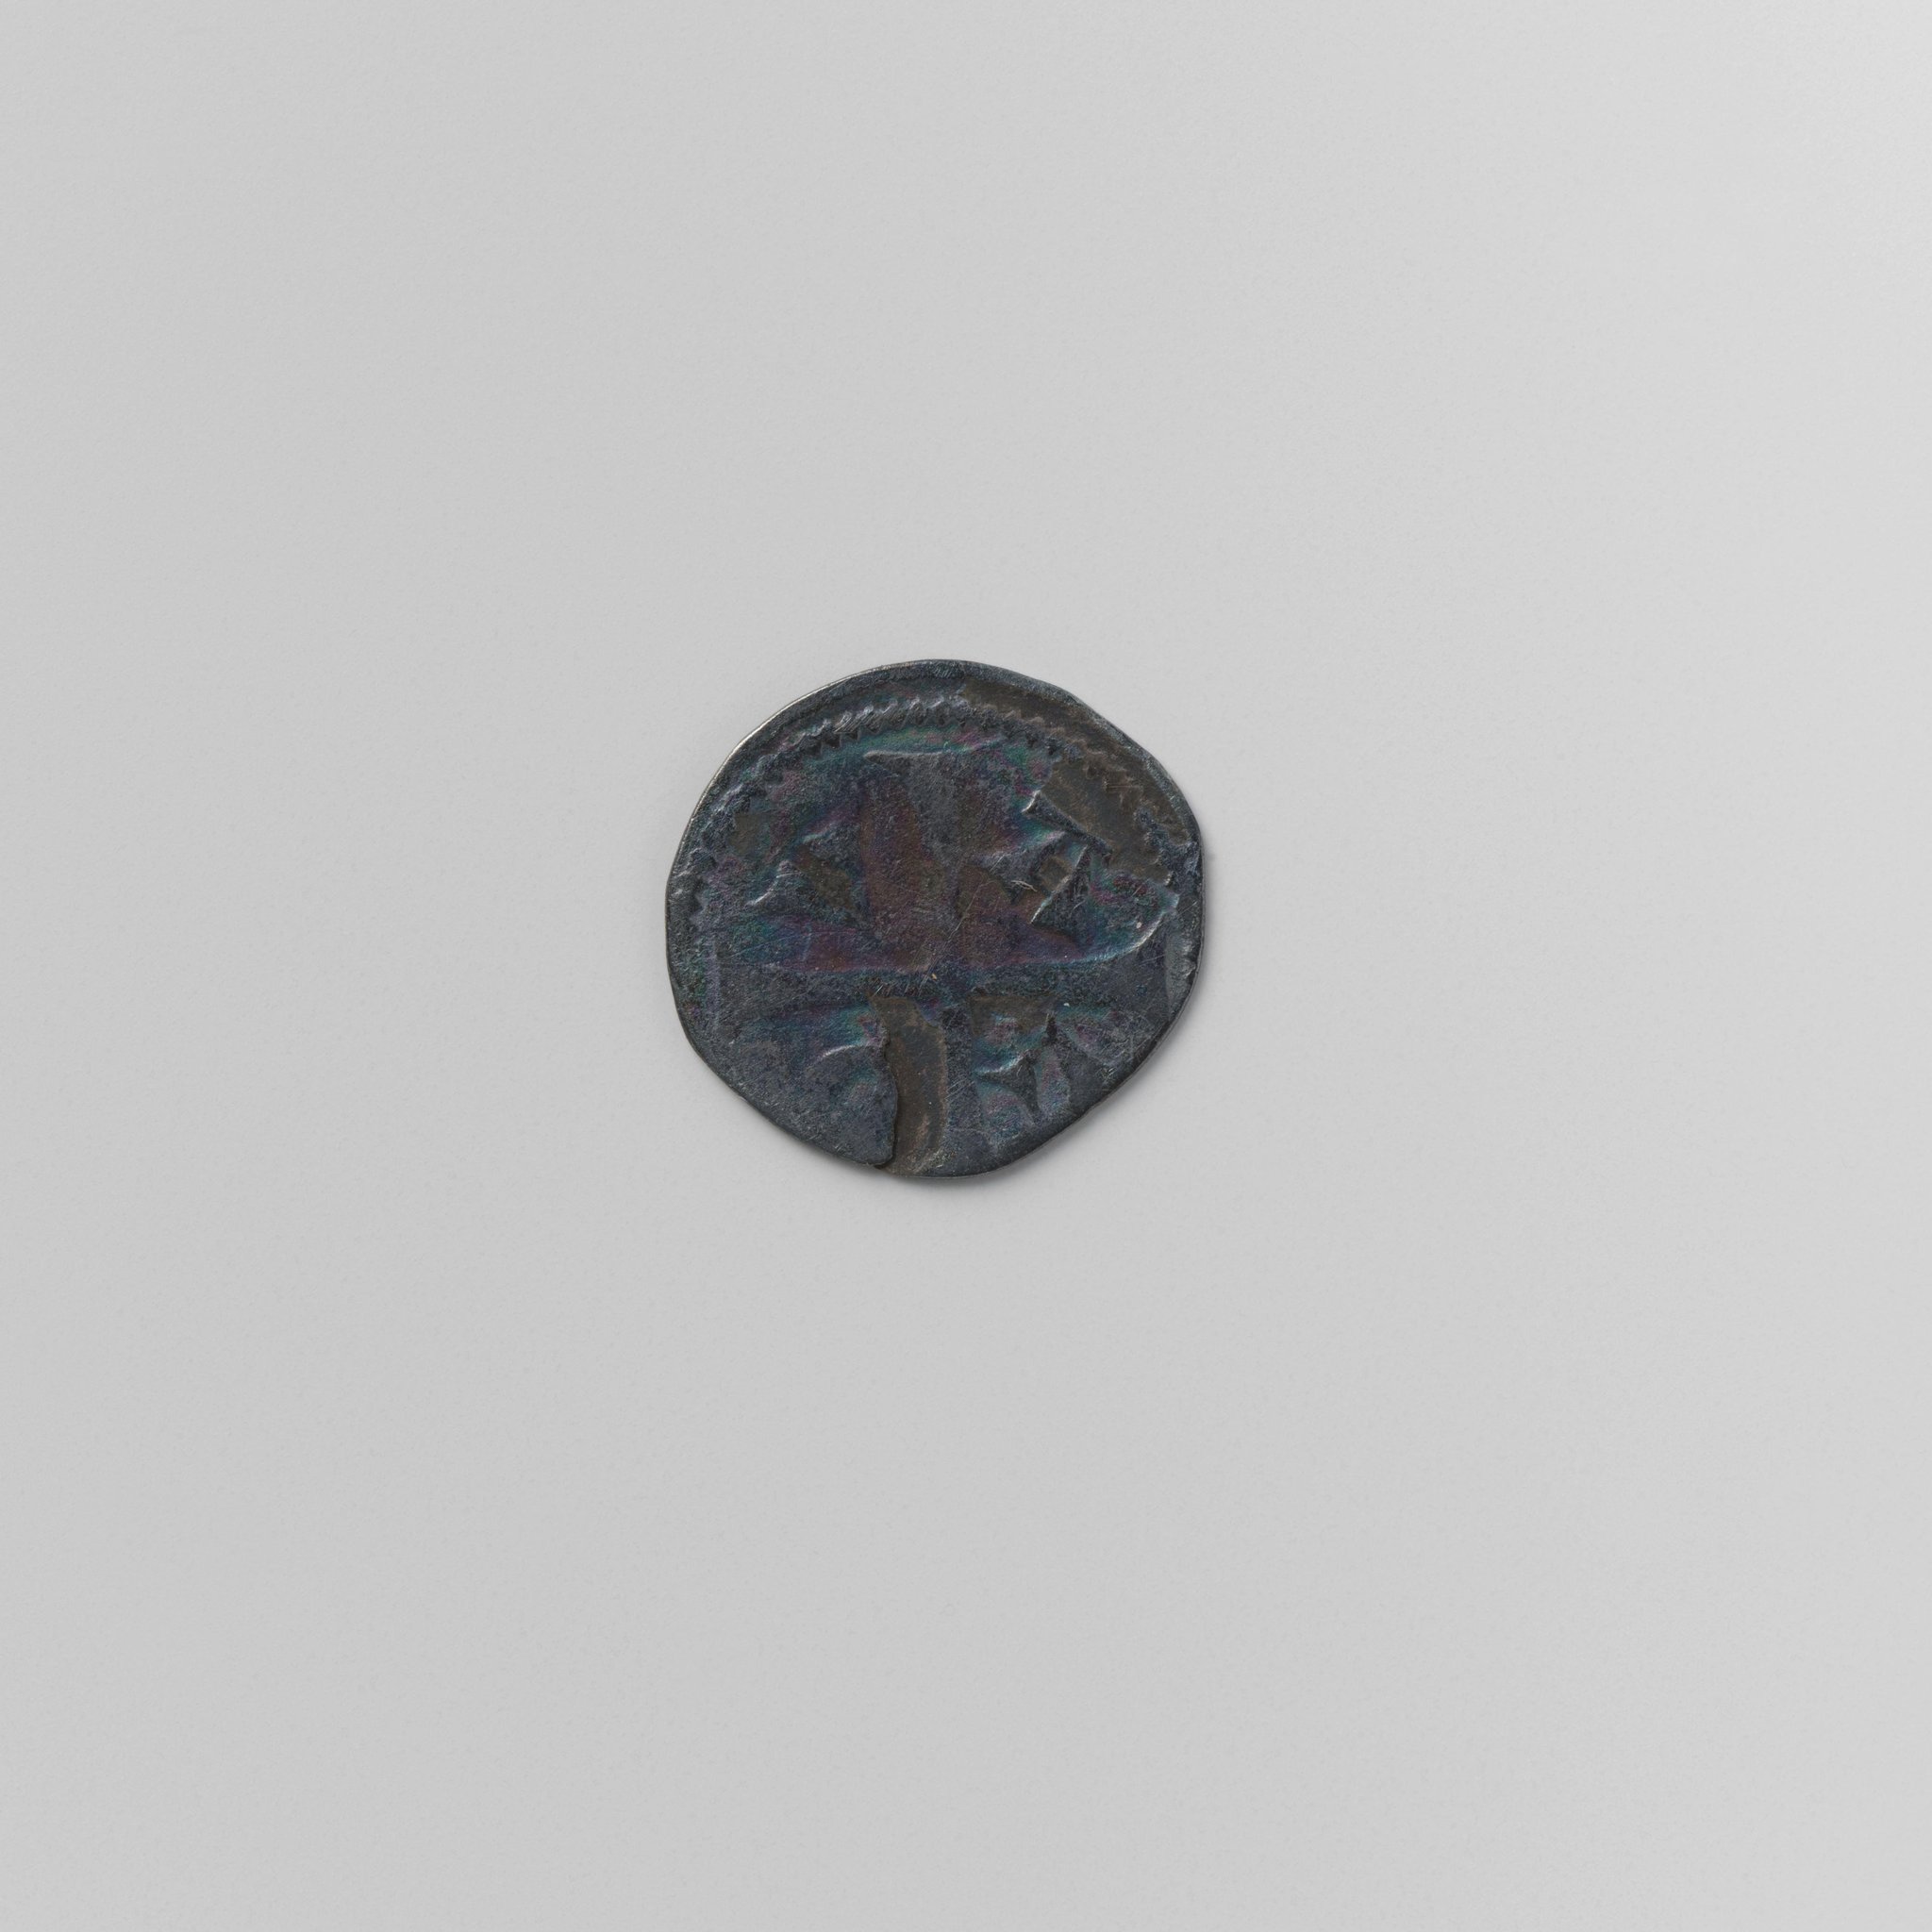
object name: coin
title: Penning uit Brabant van Jan I, 1268-1294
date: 1268-1294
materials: silver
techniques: striking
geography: leuven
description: Voorzijde: in een punt uitlopend wapenschild met leeuw, waaromheen letters I, D - VX. Keerzijde: gevoet kruis, in de hoeken letters L,O,V en A.